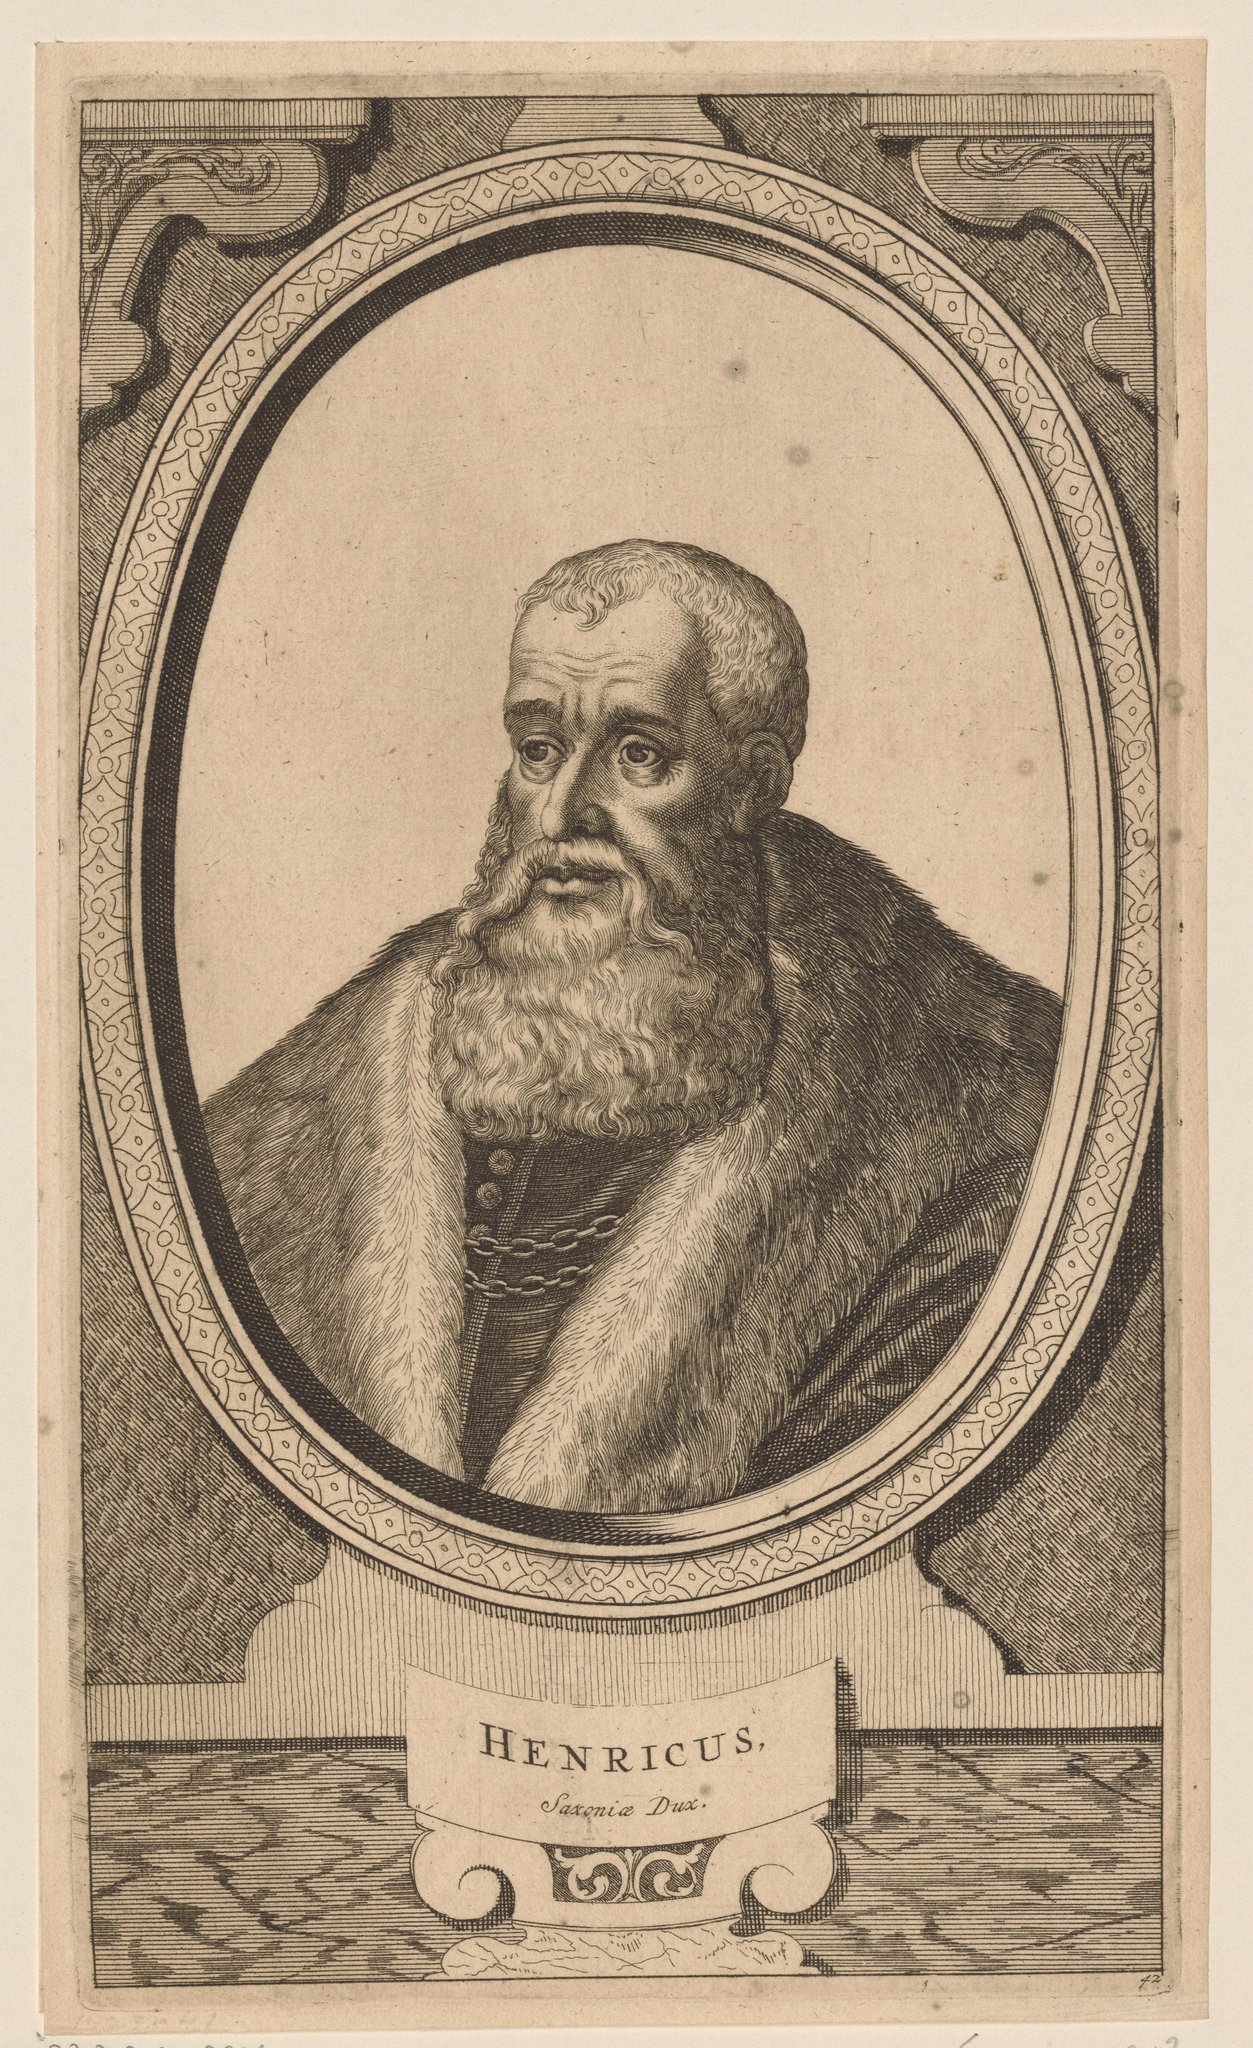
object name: print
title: Portret van Hendrik de Vrome, hertog van Saksen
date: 1682-1733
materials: paper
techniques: engraving, etching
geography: leiden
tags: historical persons